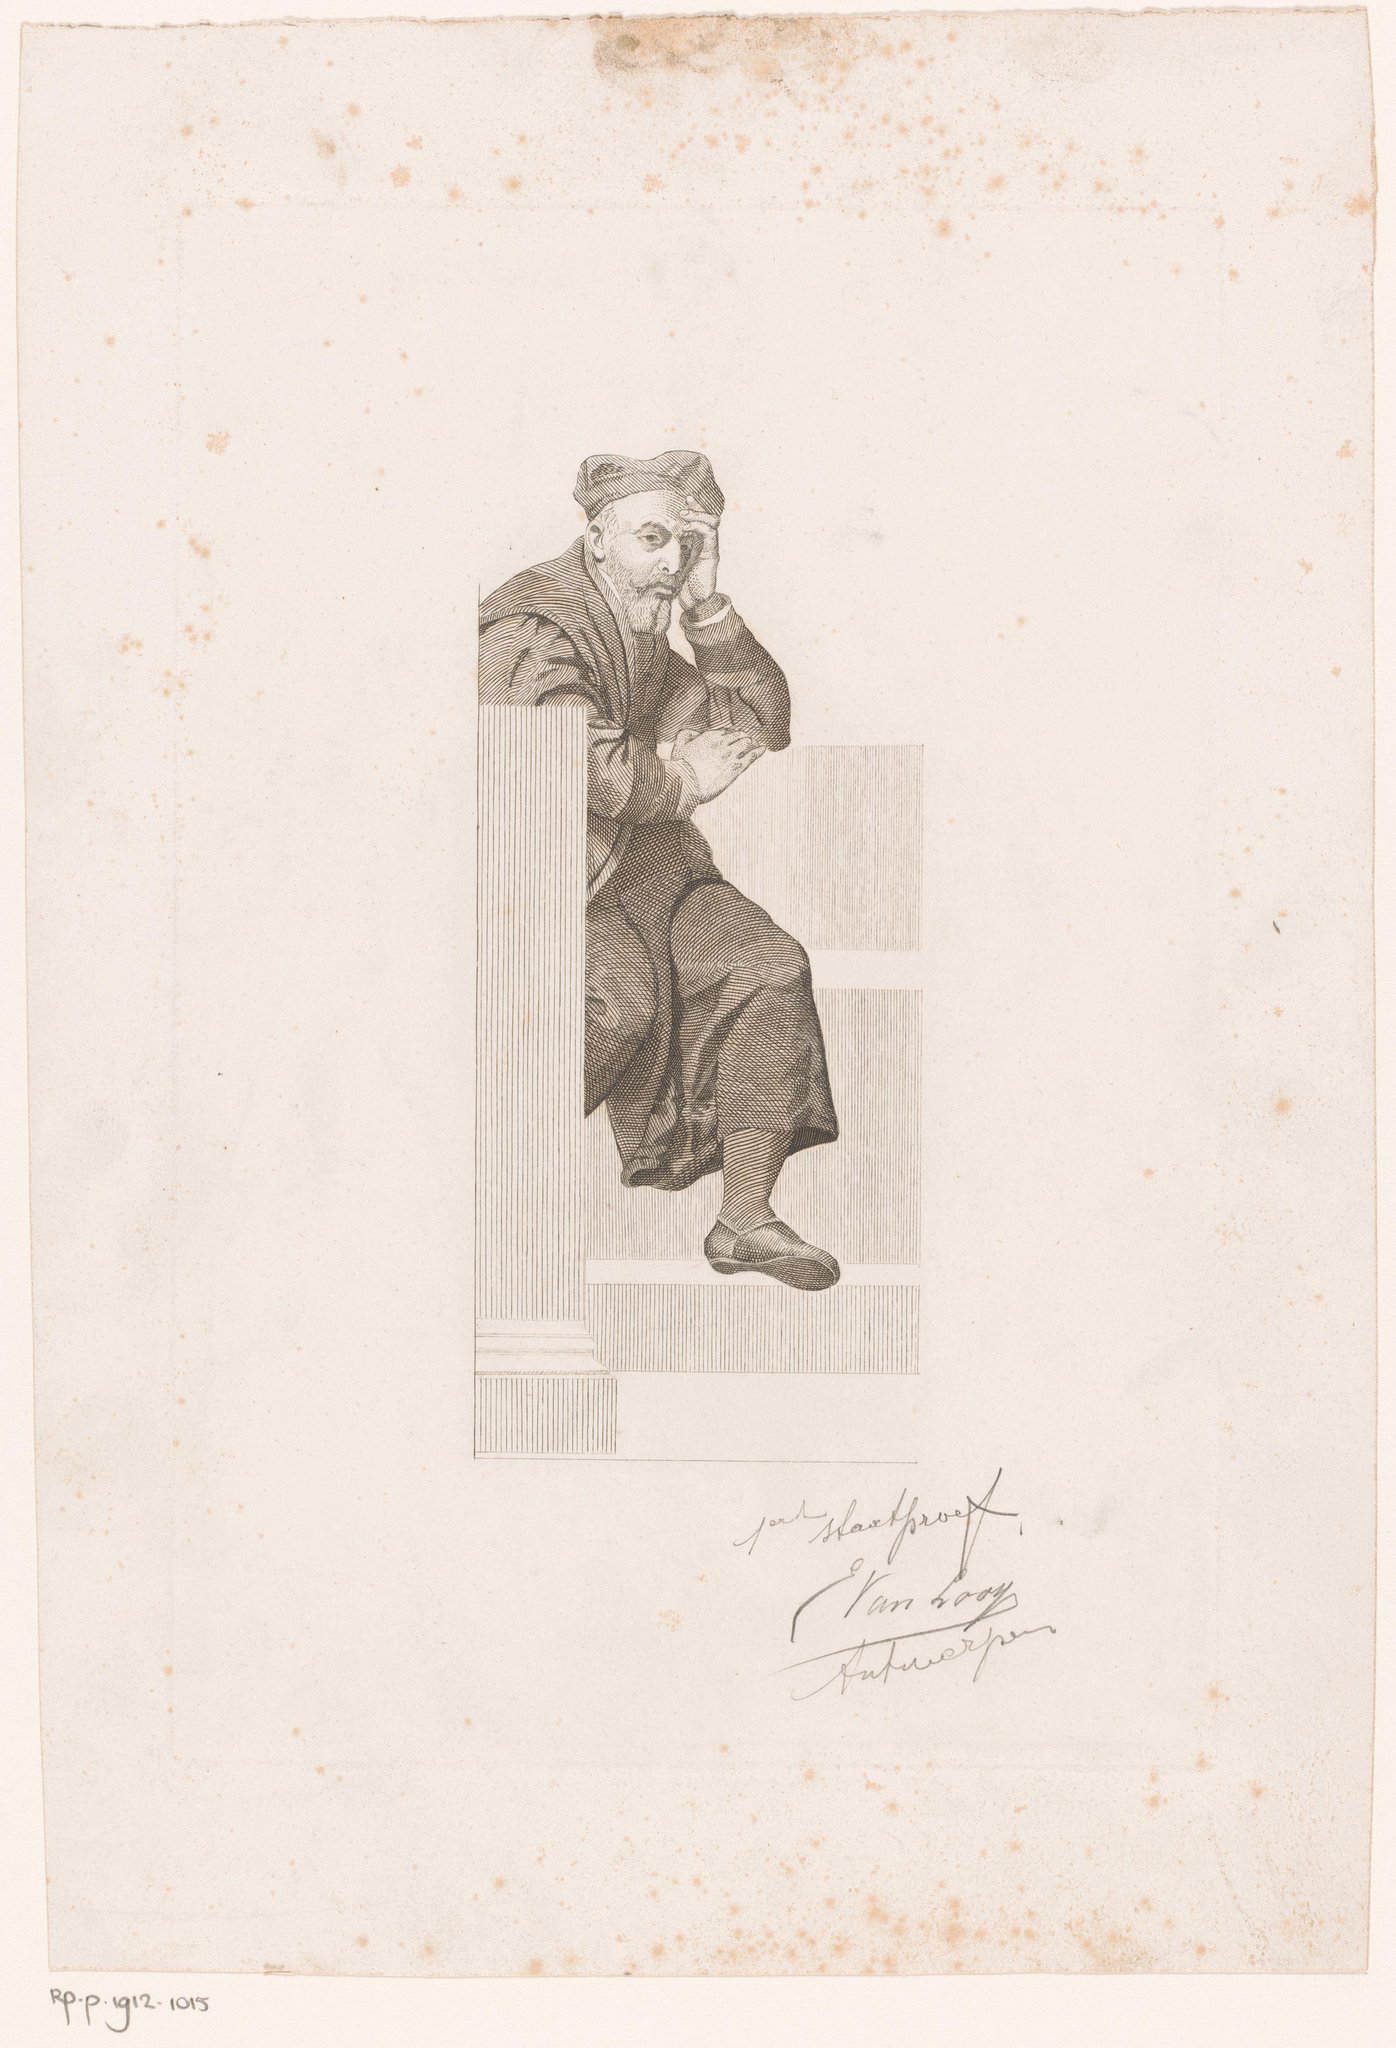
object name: print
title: Geestelijke zittend op een bank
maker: joseph edouard van looy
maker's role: print maker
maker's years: 1871-1896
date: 1888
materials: paper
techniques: etching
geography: antwerp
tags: seats of the clergy, choir-stalls, organization, functionaries and dignitaries in roman catholic church; clergy in general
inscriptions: collector's mark: Lugt 2228, annotation: ‘1ste staat proef’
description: Sterfdatum van de prentmaker is onbekend. Daarom is voor de bepaling van de rechten van dit object gebruik gemaakt van de verwervingsdatum Rijksmuseum Amsterdam.